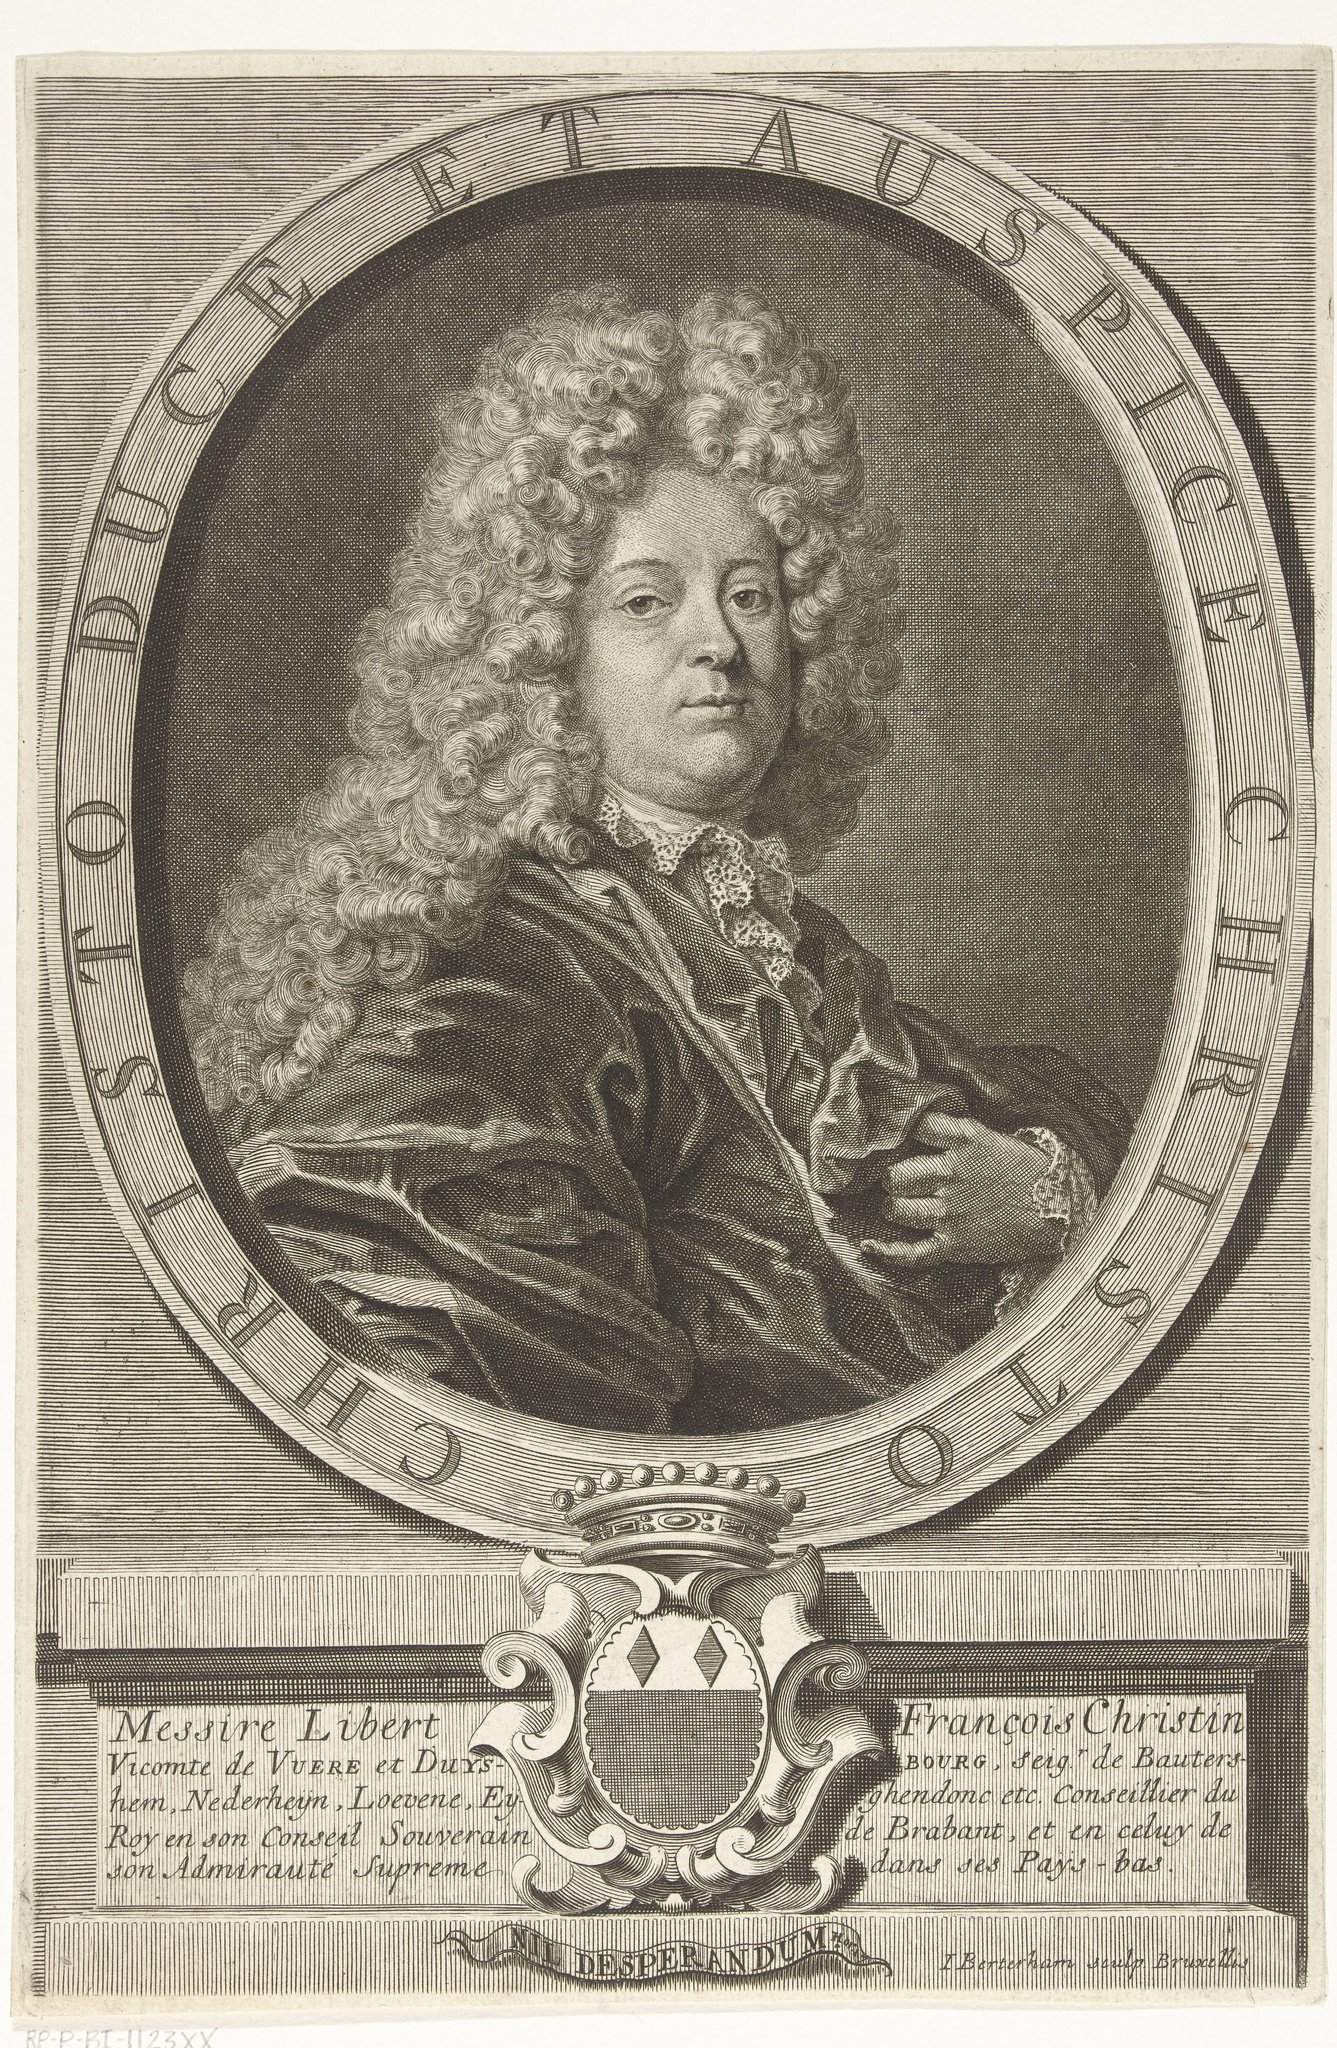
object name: print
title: Messire Libert Francois (...) dans ses Pays-bas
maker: jan baptist berterham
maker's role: print maker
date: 1696-1721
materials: paper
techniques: engraving, etching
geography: brussels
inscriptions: collector's mark: Lugt 2228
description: Portret van Libert Francois II Christyn in ovale omlijsting met motto. Onder de lijst een wapenschild in rolwerk en lint met tekst van Horatius.